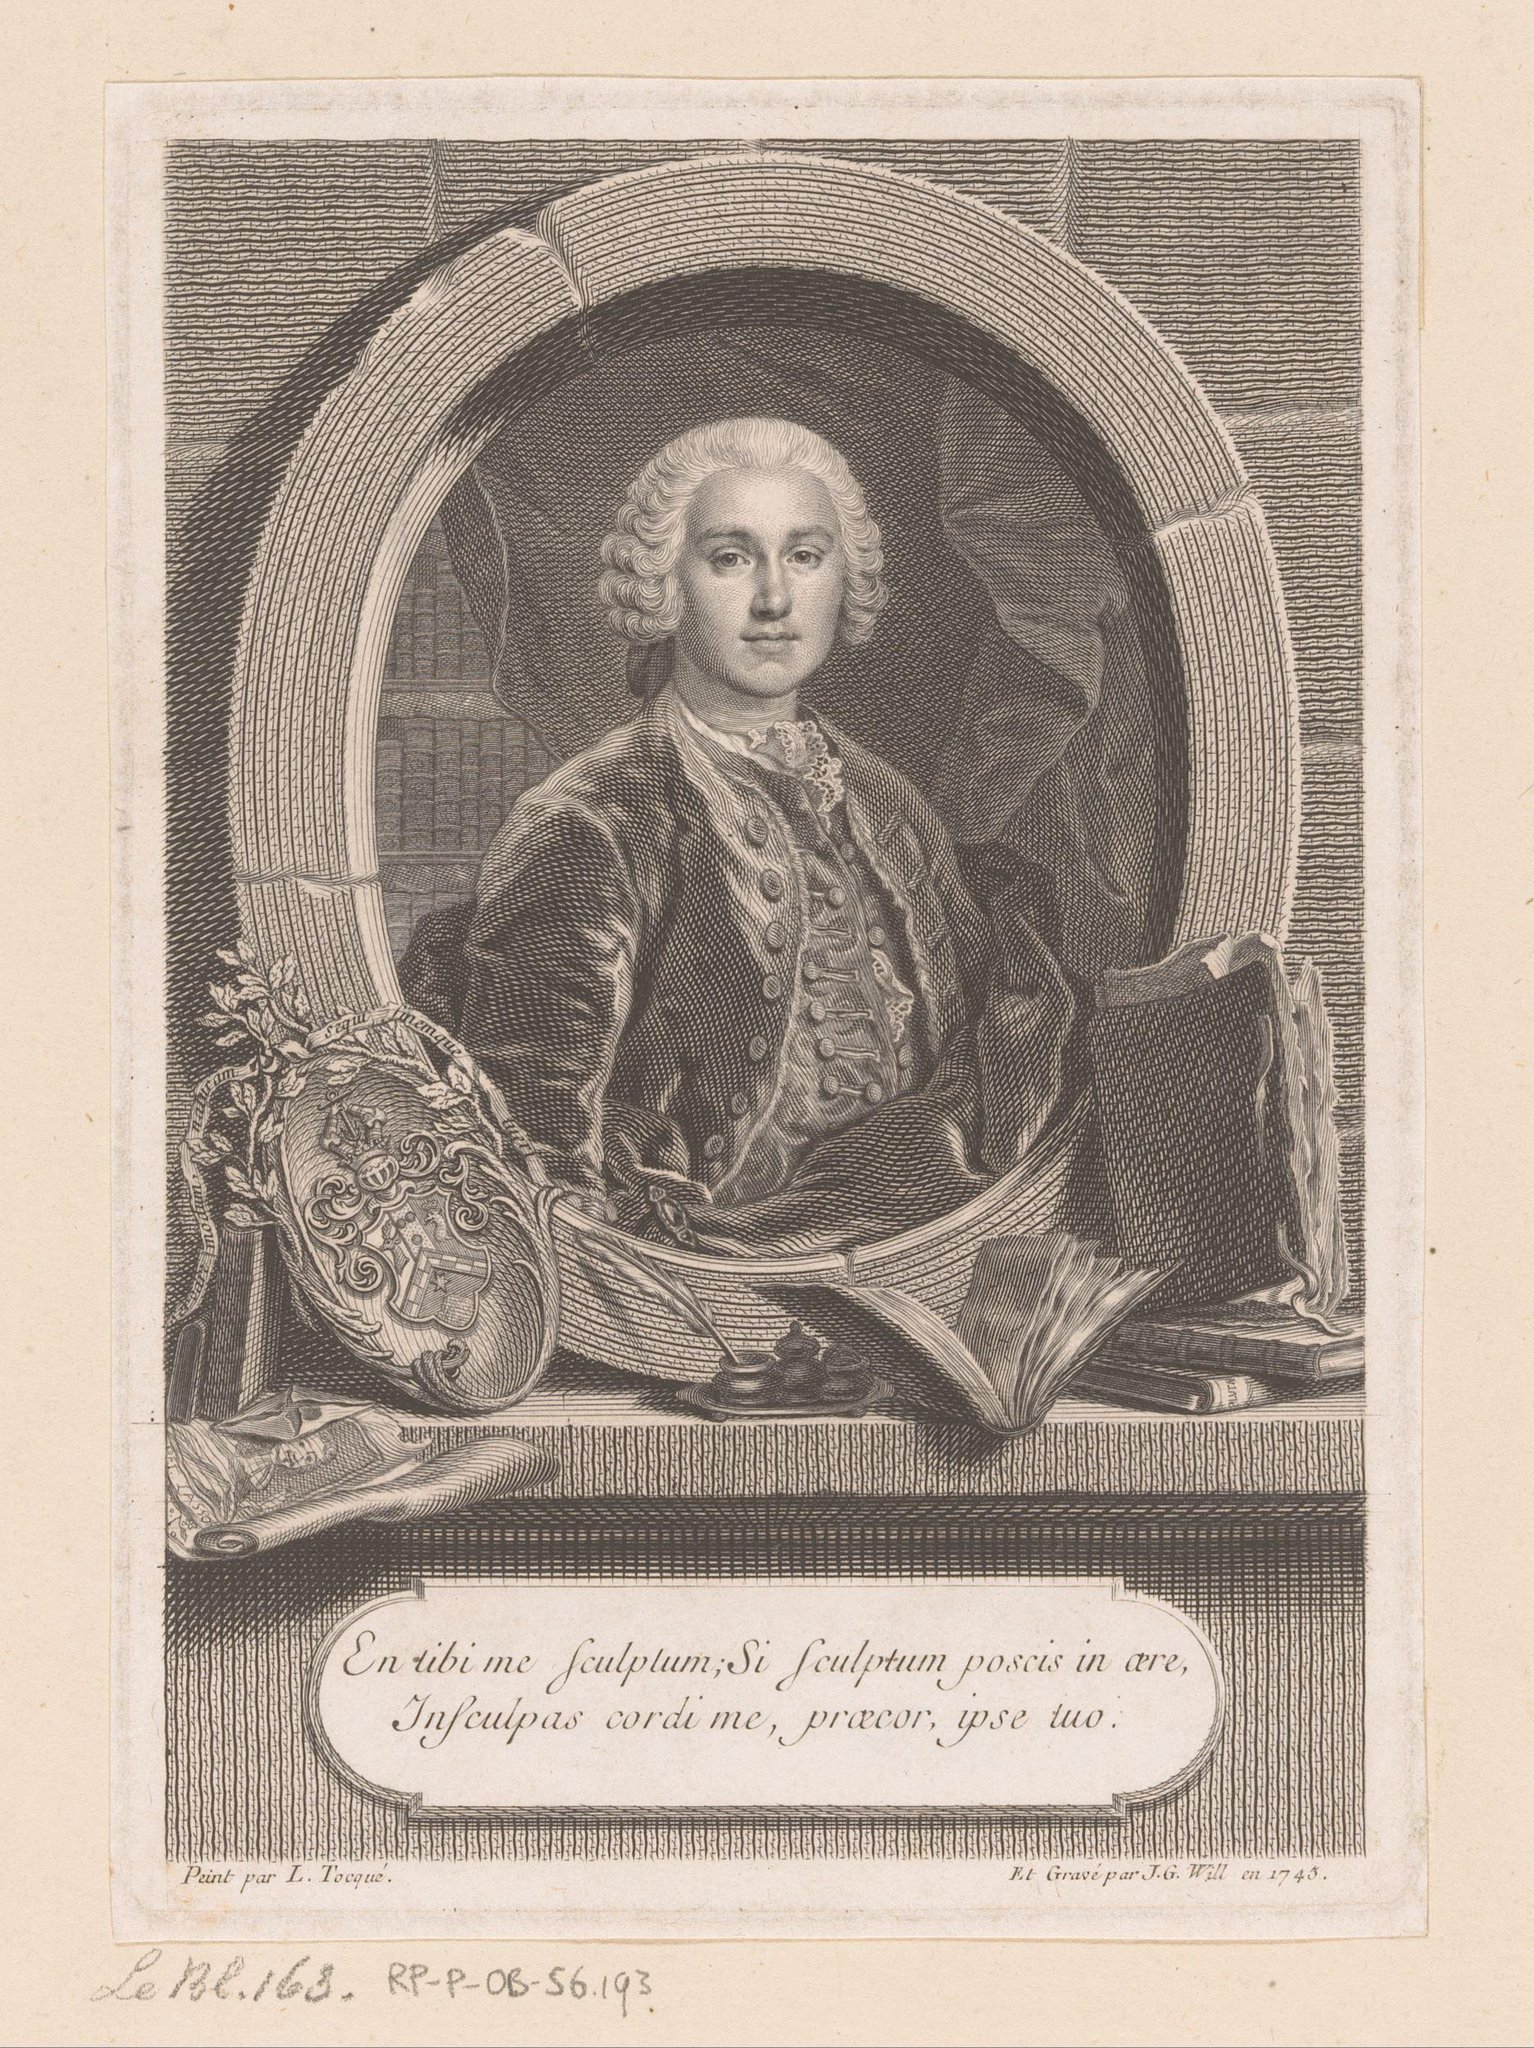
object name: print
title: Portret van Tycho de Hofman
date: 1745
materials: paper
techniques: engraving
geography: paris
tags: historical persons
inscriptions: collector's mark: Lugt 240